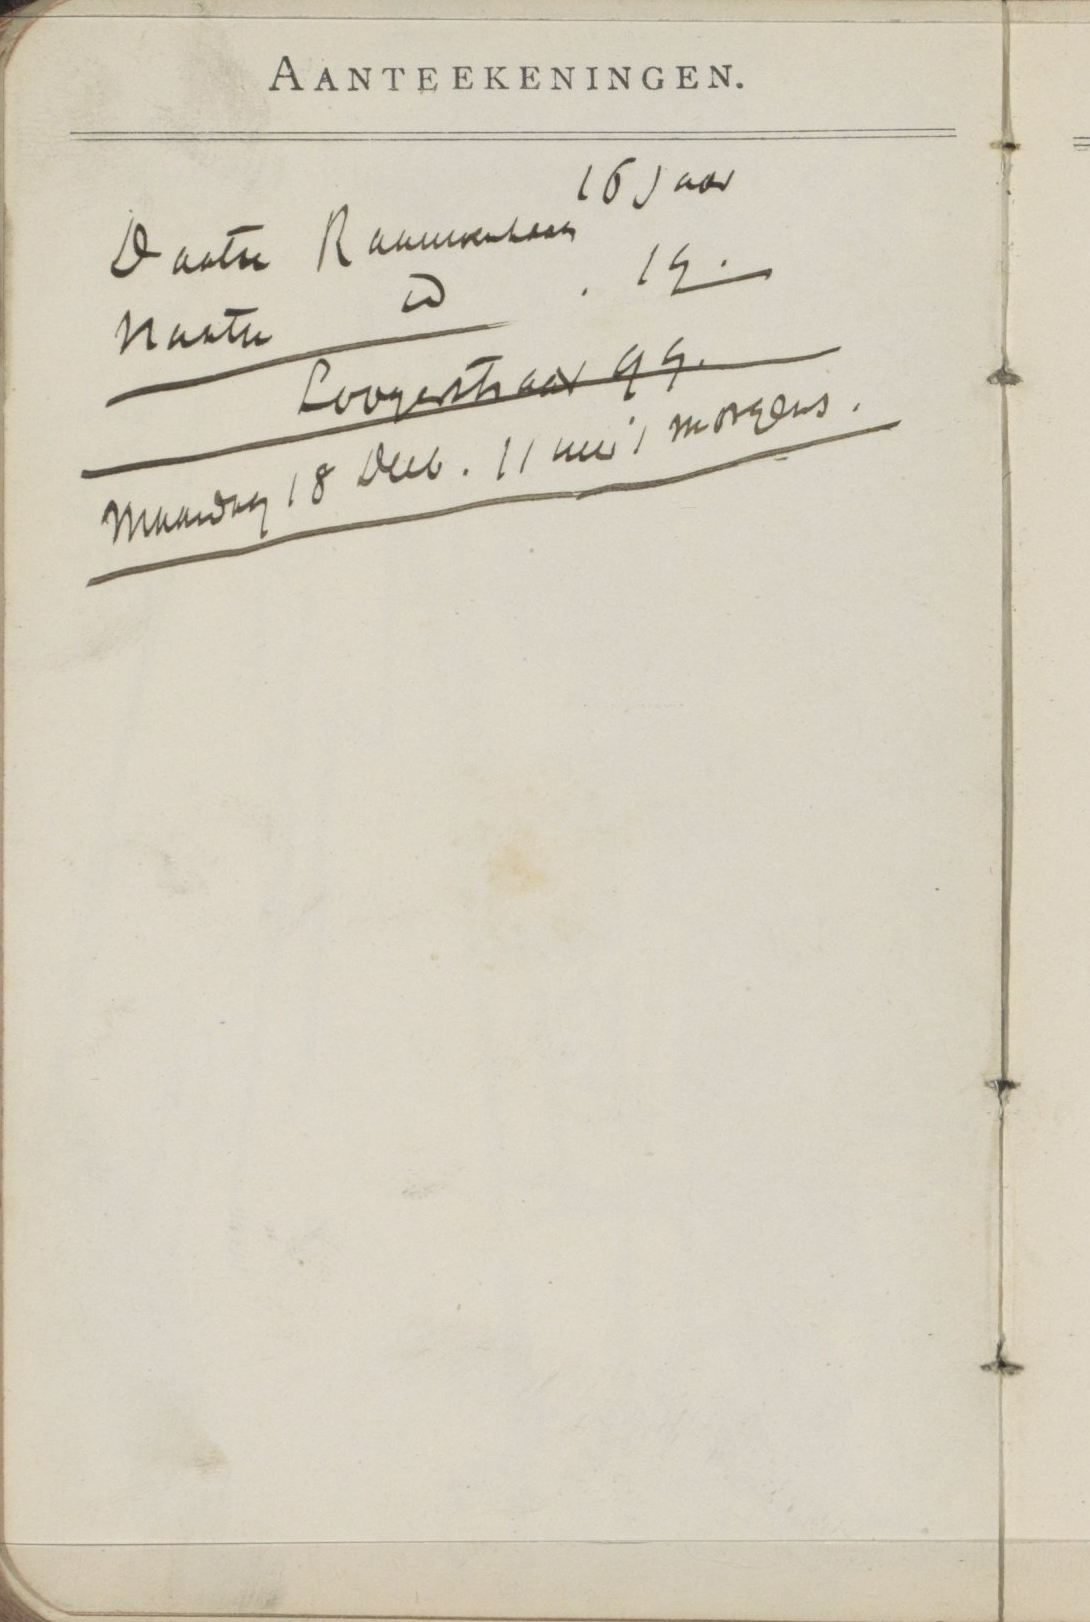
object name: sketchbook leaf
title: Annotaties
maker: george hendrik breitner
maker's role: draughtsman, painter, print maker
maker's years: 1857-1923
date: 1893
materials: ink, paper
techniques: writing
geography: amsterdam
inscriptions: annotation: ‘Daatje[?] Ra[...] 16 jaar/ Naatje id 14./ Looyerstraat 99/ Maandag 18 Dece. 11 uur 's morgens’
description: Pagina 209 uit een als schetsboek gebruikte agenda met 108 bladen.